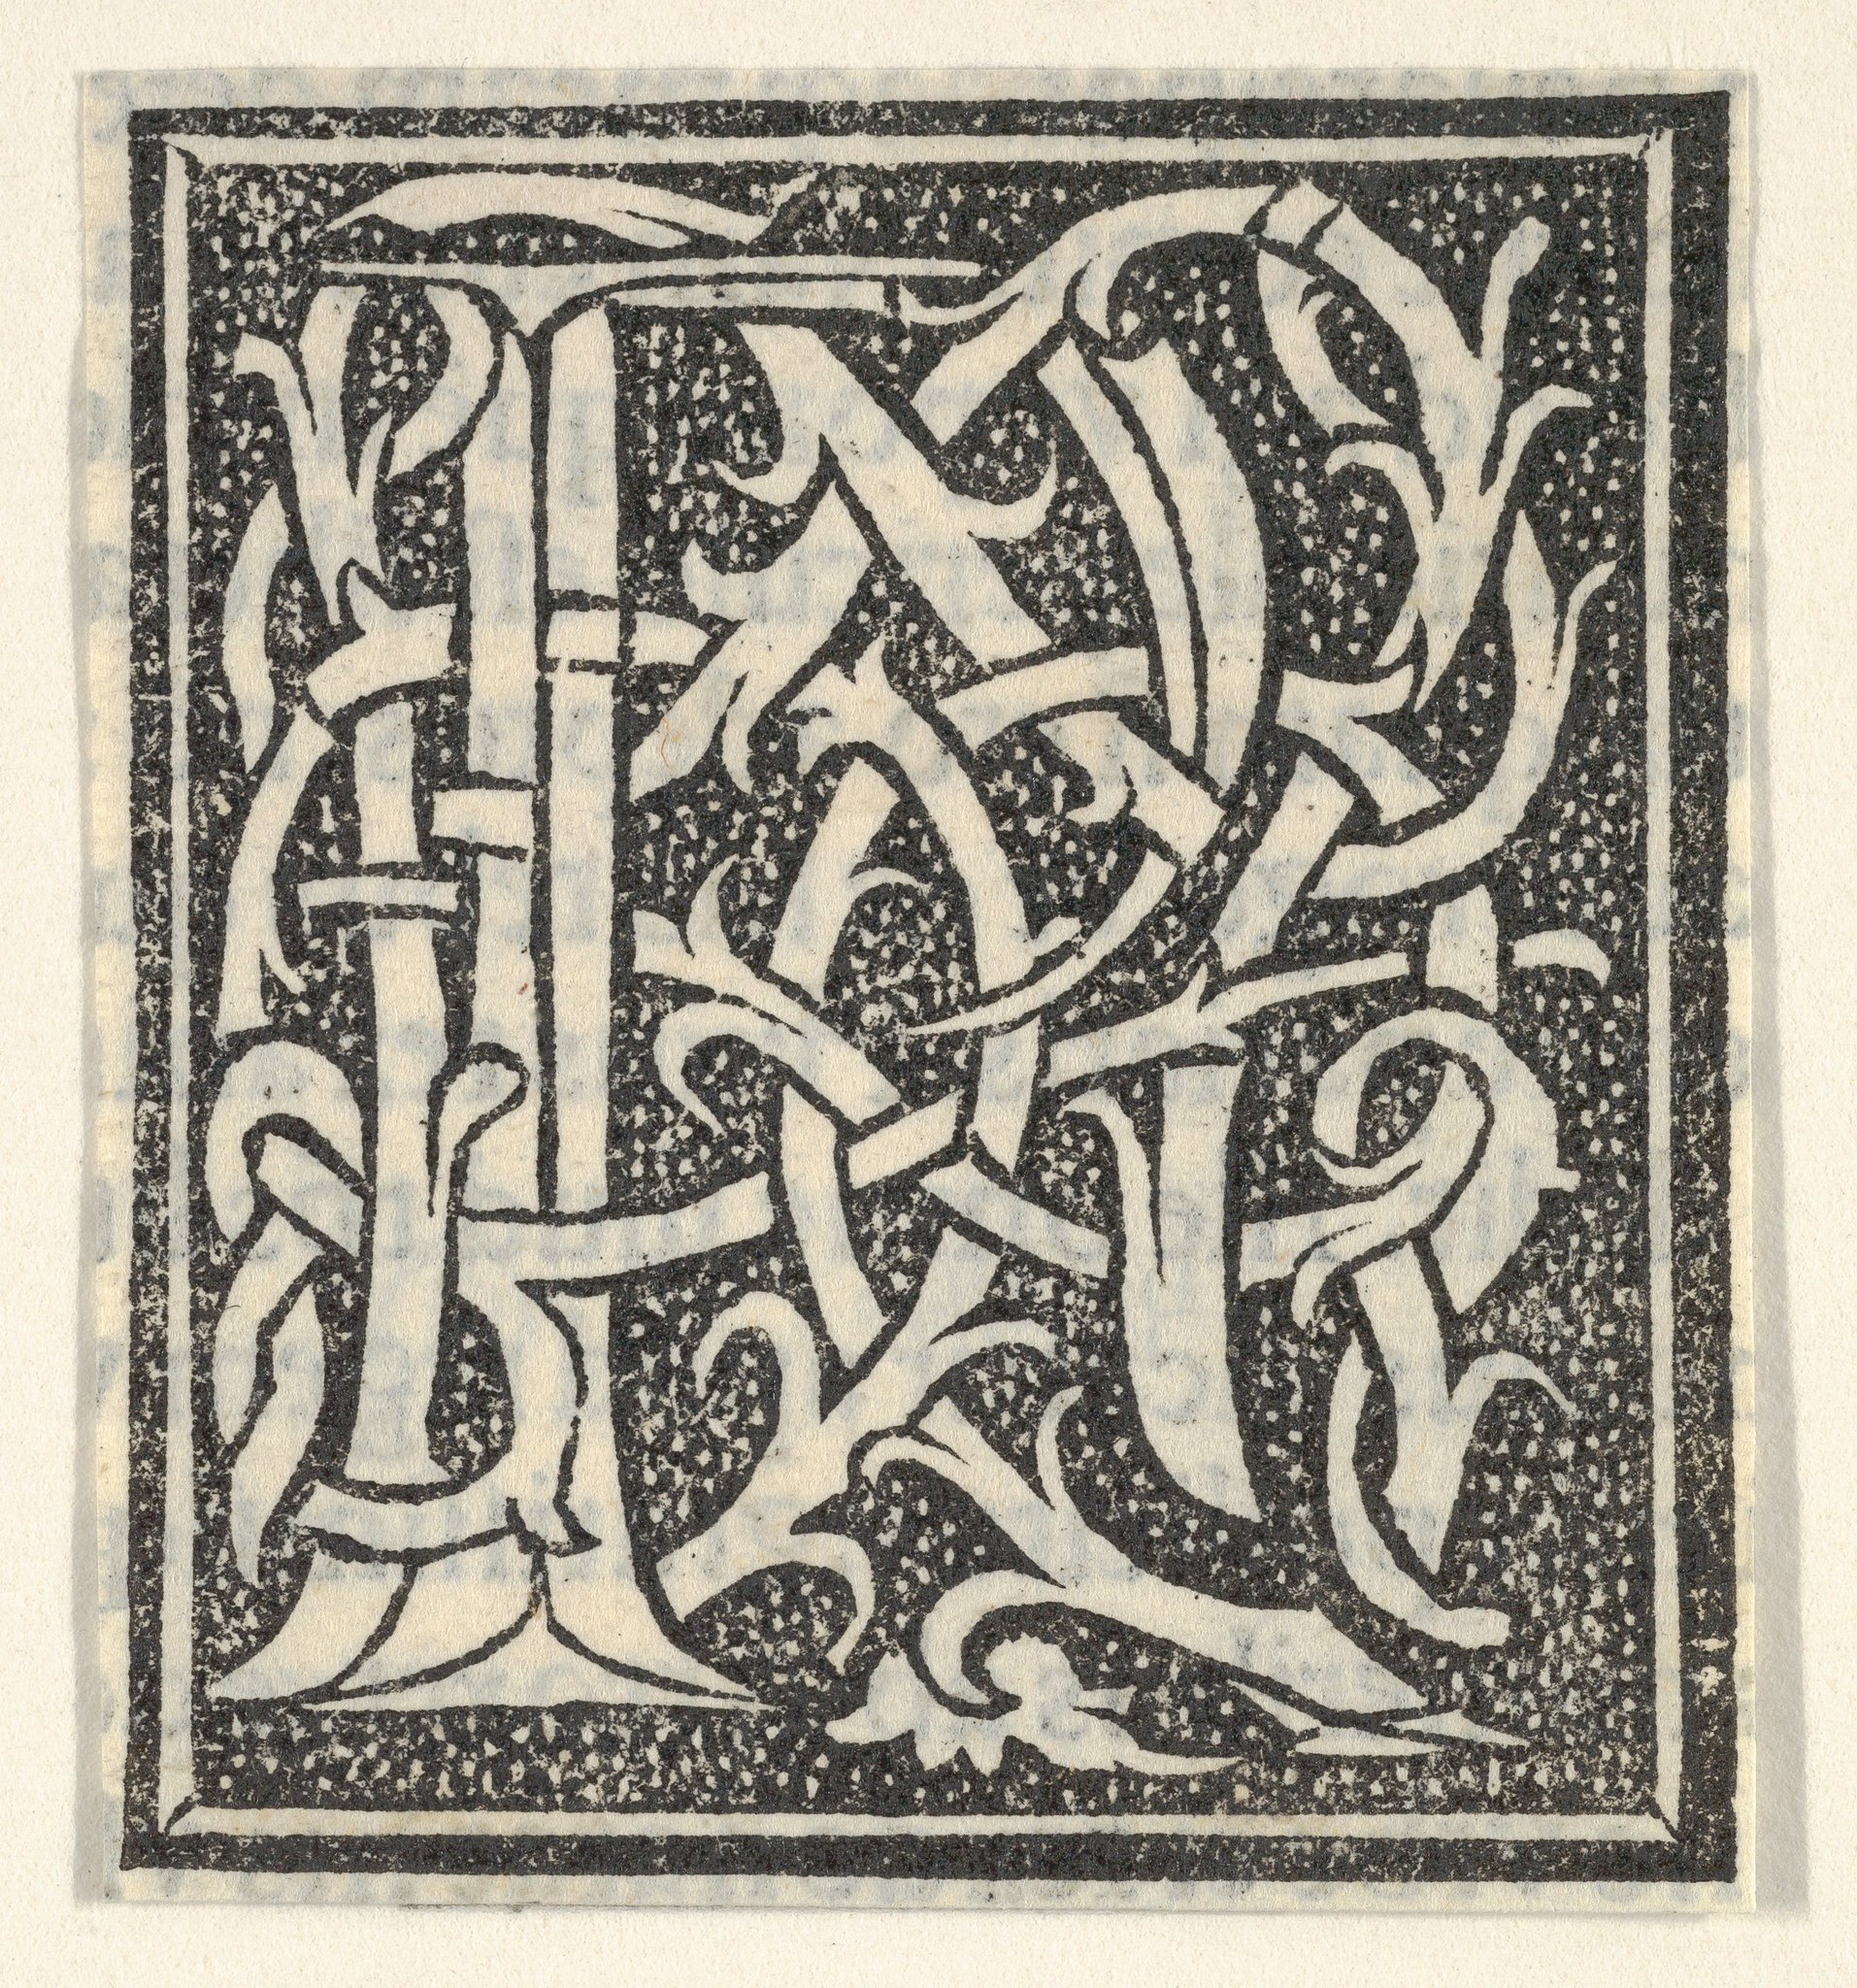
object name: print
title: Initial letter P on patterned background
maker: anonymous, italian, 16th century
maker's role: artist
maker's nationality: italian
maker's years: 1500-1600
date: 1520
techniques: woodcut